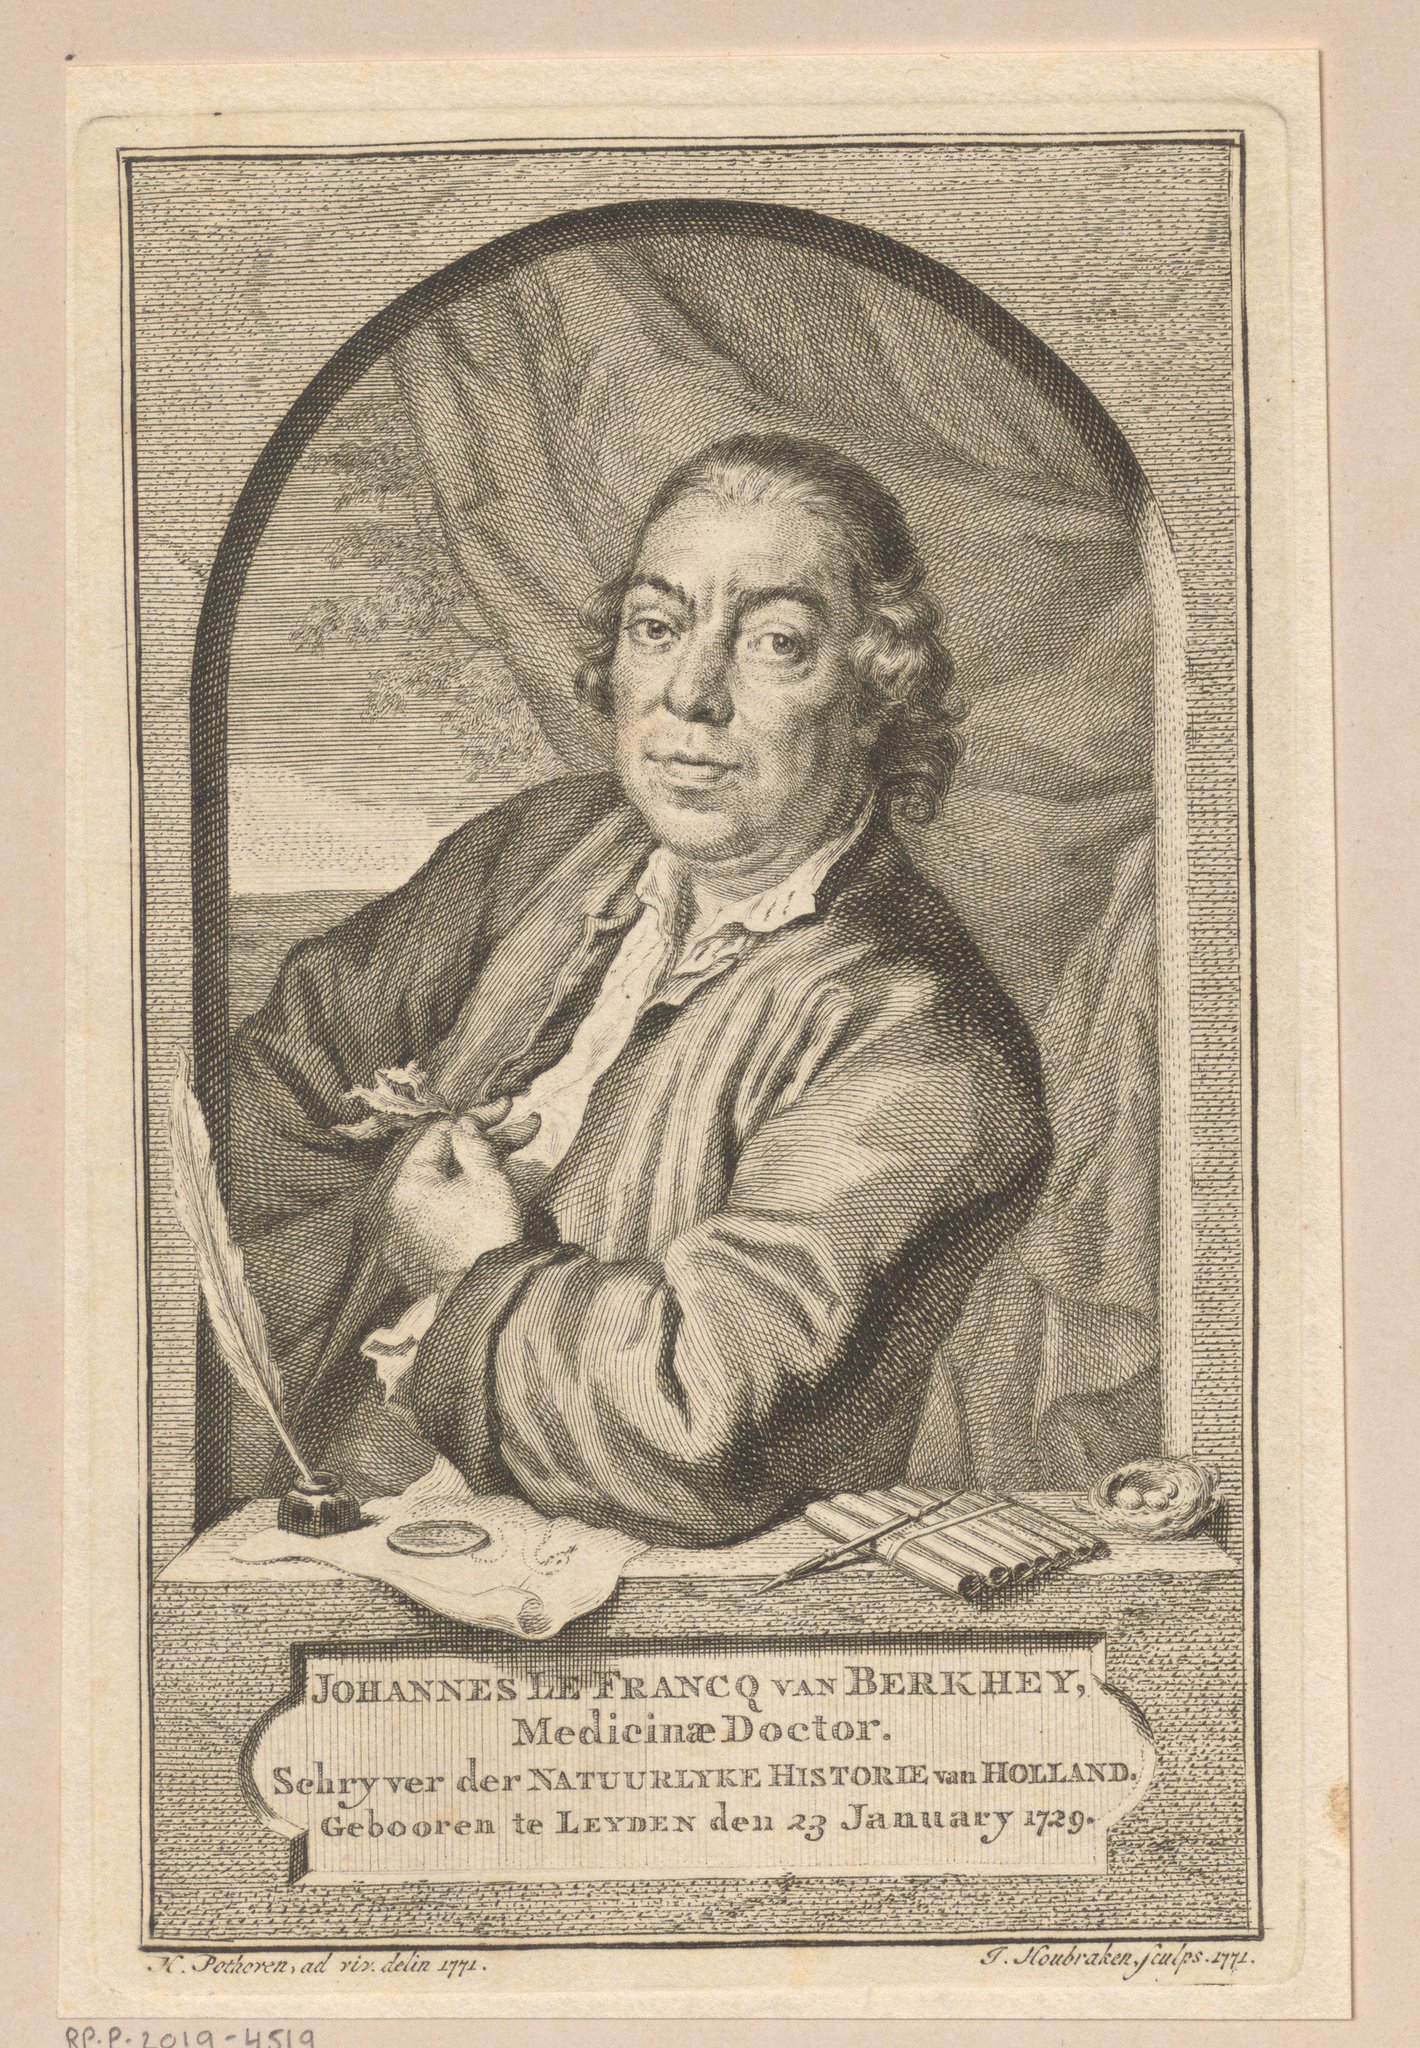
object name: print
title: Portret van Johannes le Francq van Berkhey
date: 1771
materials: paper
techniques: engraving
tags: print maker, draughtsman, johannes le francq van berkhey, historical persons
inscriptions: date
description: Prent ook gebruikt in: Francq van Berkhey, Johannes le. Het verheerlijkt Leyden, bij het tweede eeuwgetijde van deszelfs heuchlijk ontzet (...). Leiden: Hendrik Coster, Cornelis Heyligert en Hendrik Hoogenstraten, 1774.